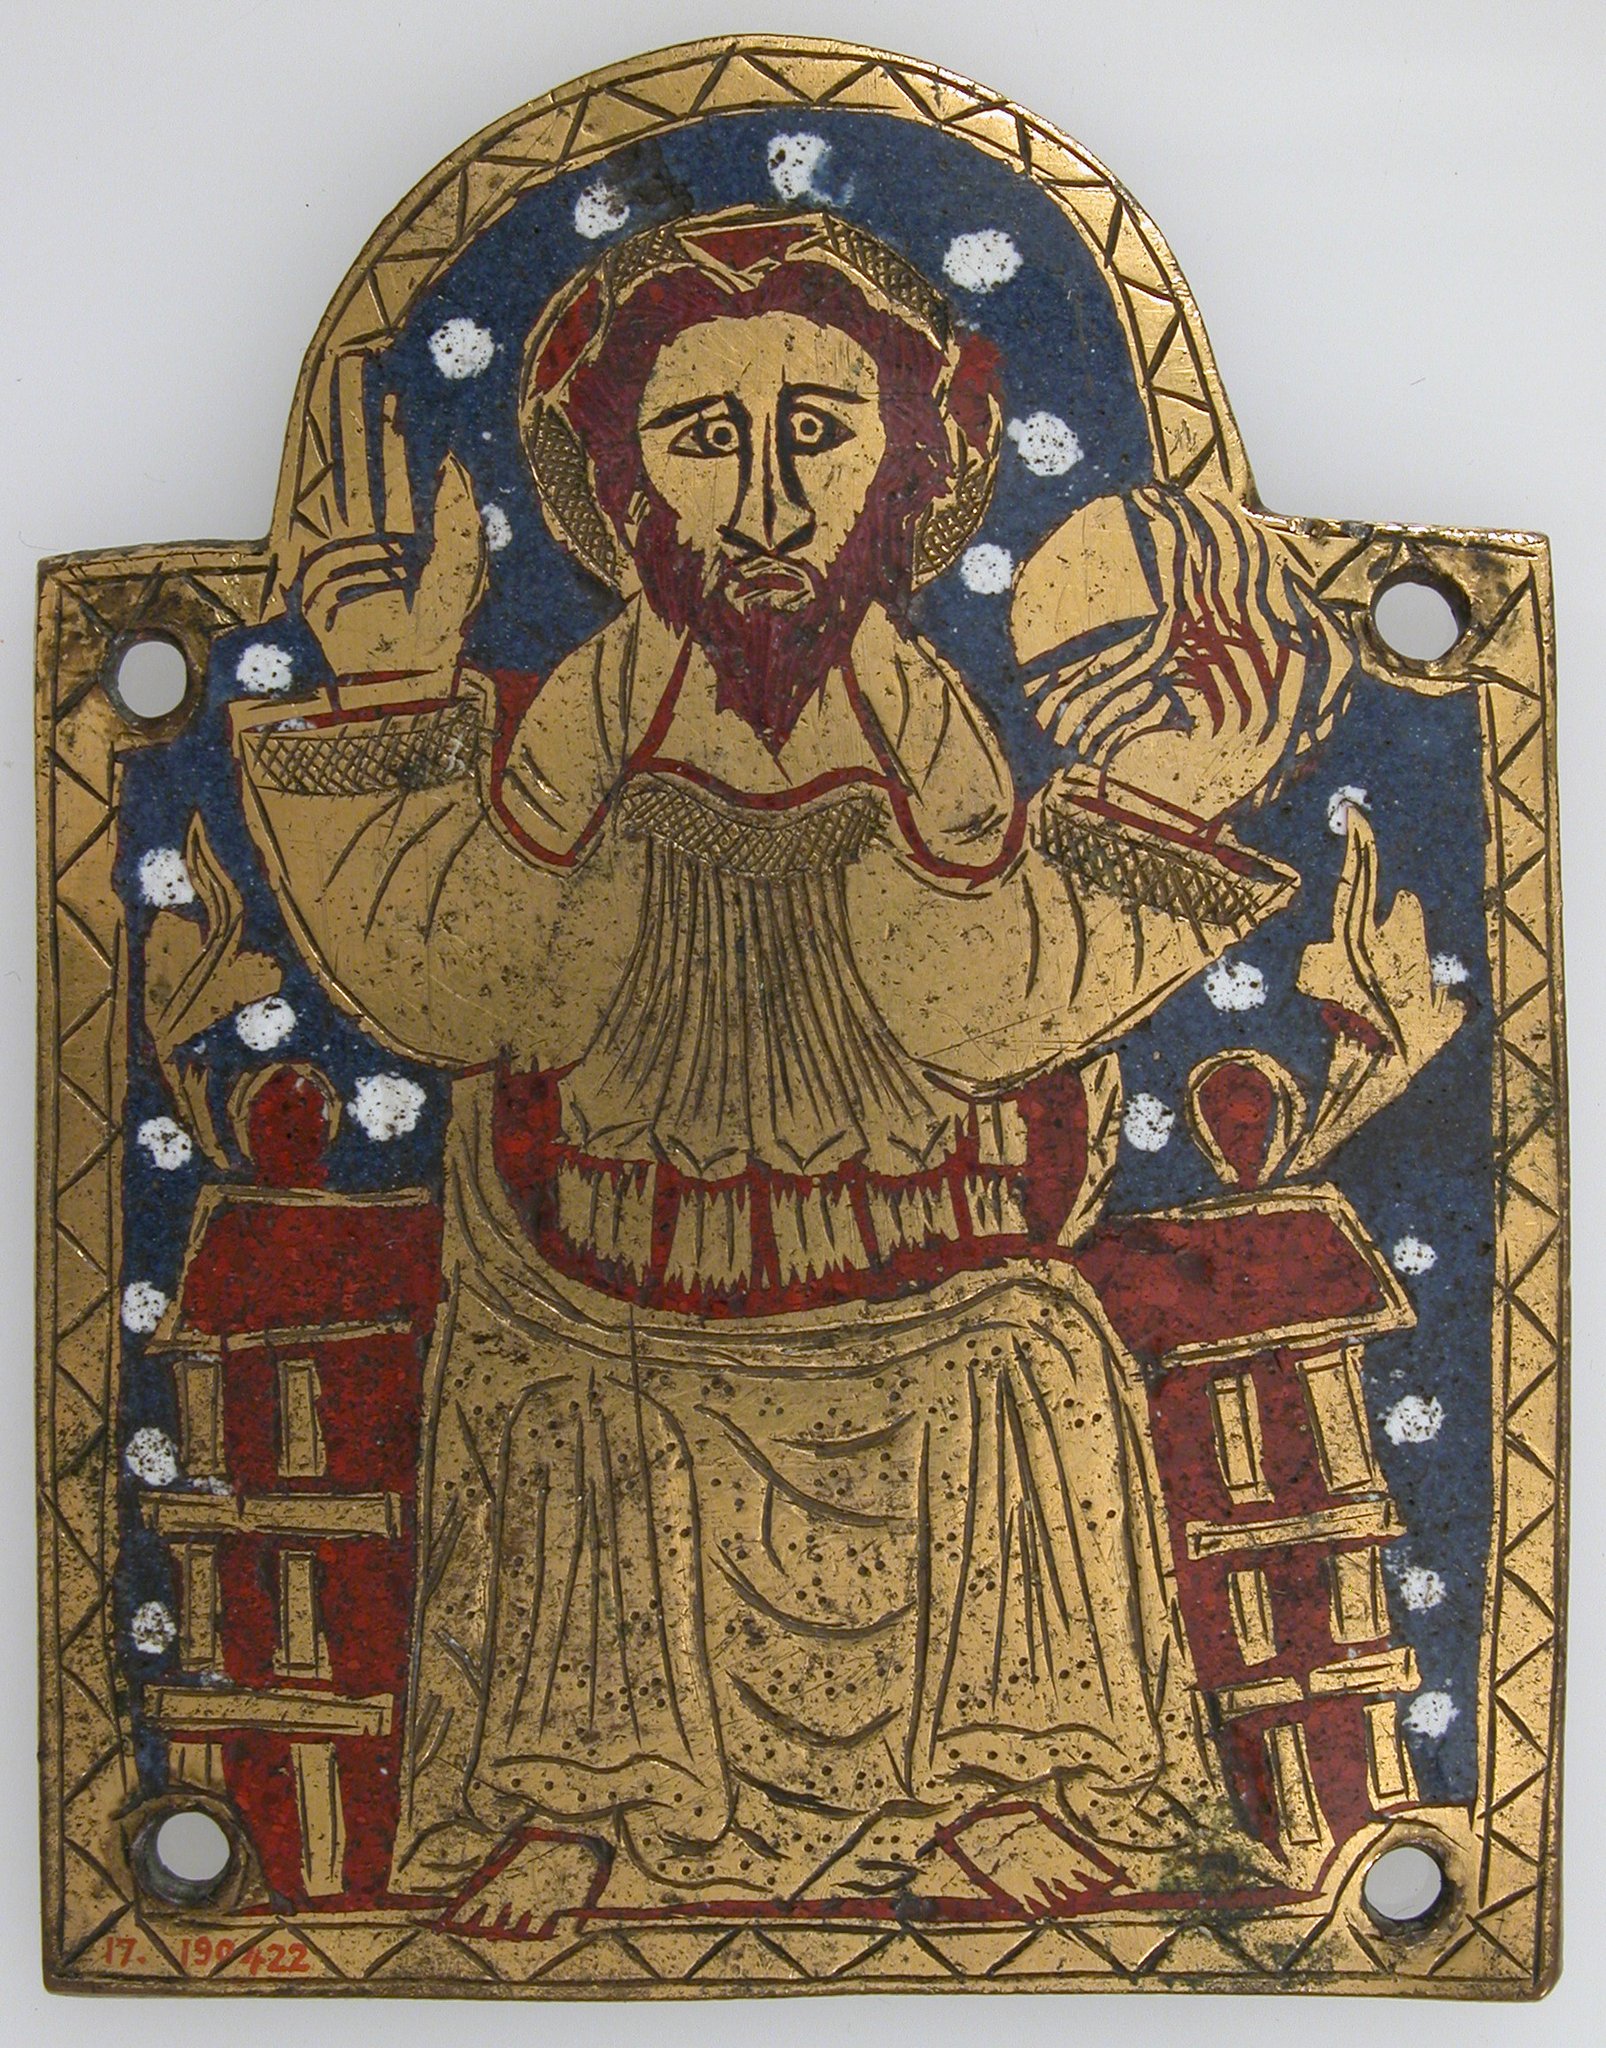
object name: plaque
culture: spanish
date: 1301-1400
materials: copper, enamel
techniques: enamel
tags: men,portraits